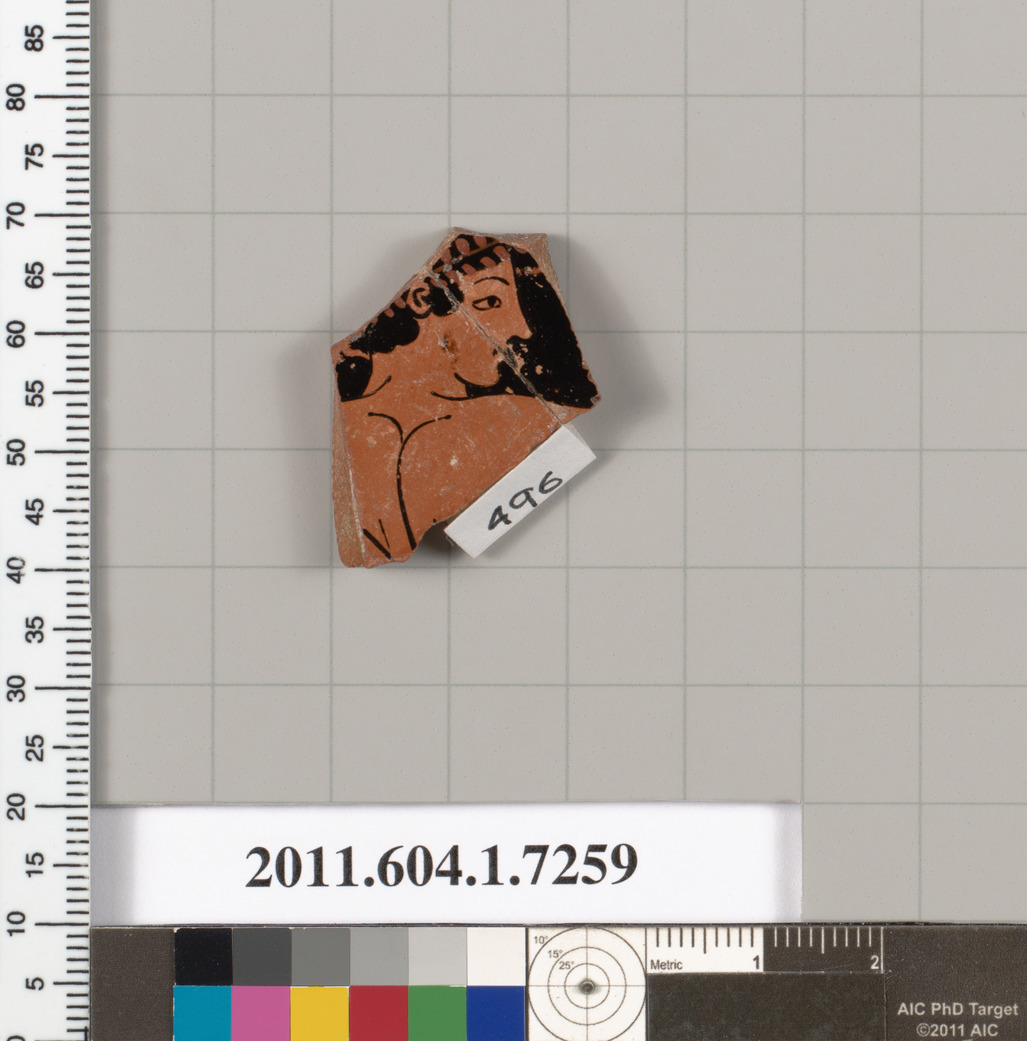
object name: kylix fragment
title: Terracotta fragment of a kylix (drinking cup)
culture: greek, attic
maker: makron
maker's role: artist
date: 500-480 BCE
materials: terracotta